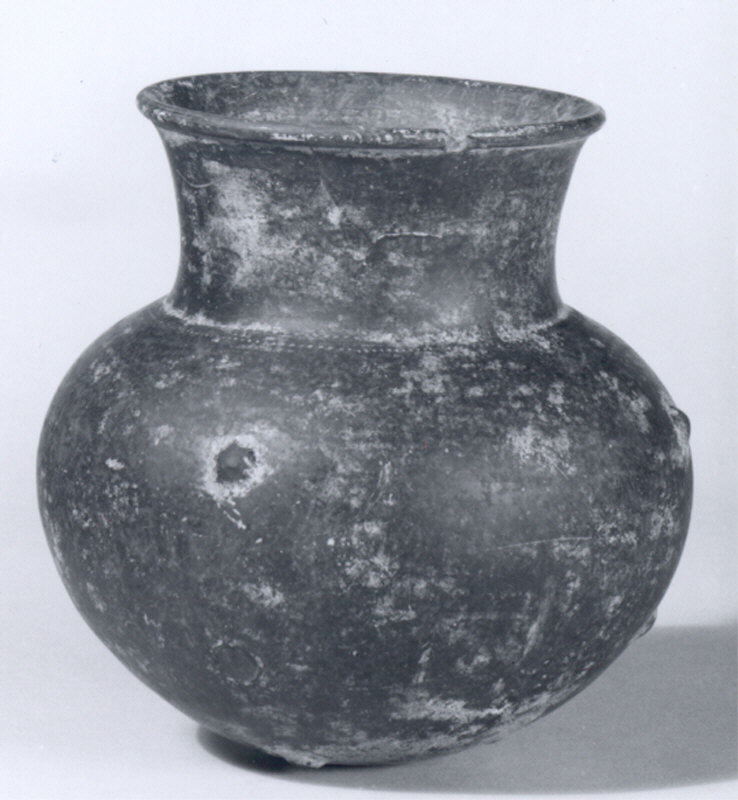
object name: jar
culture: iranian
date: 1000 BCE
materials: ceramic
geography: northwestern iran